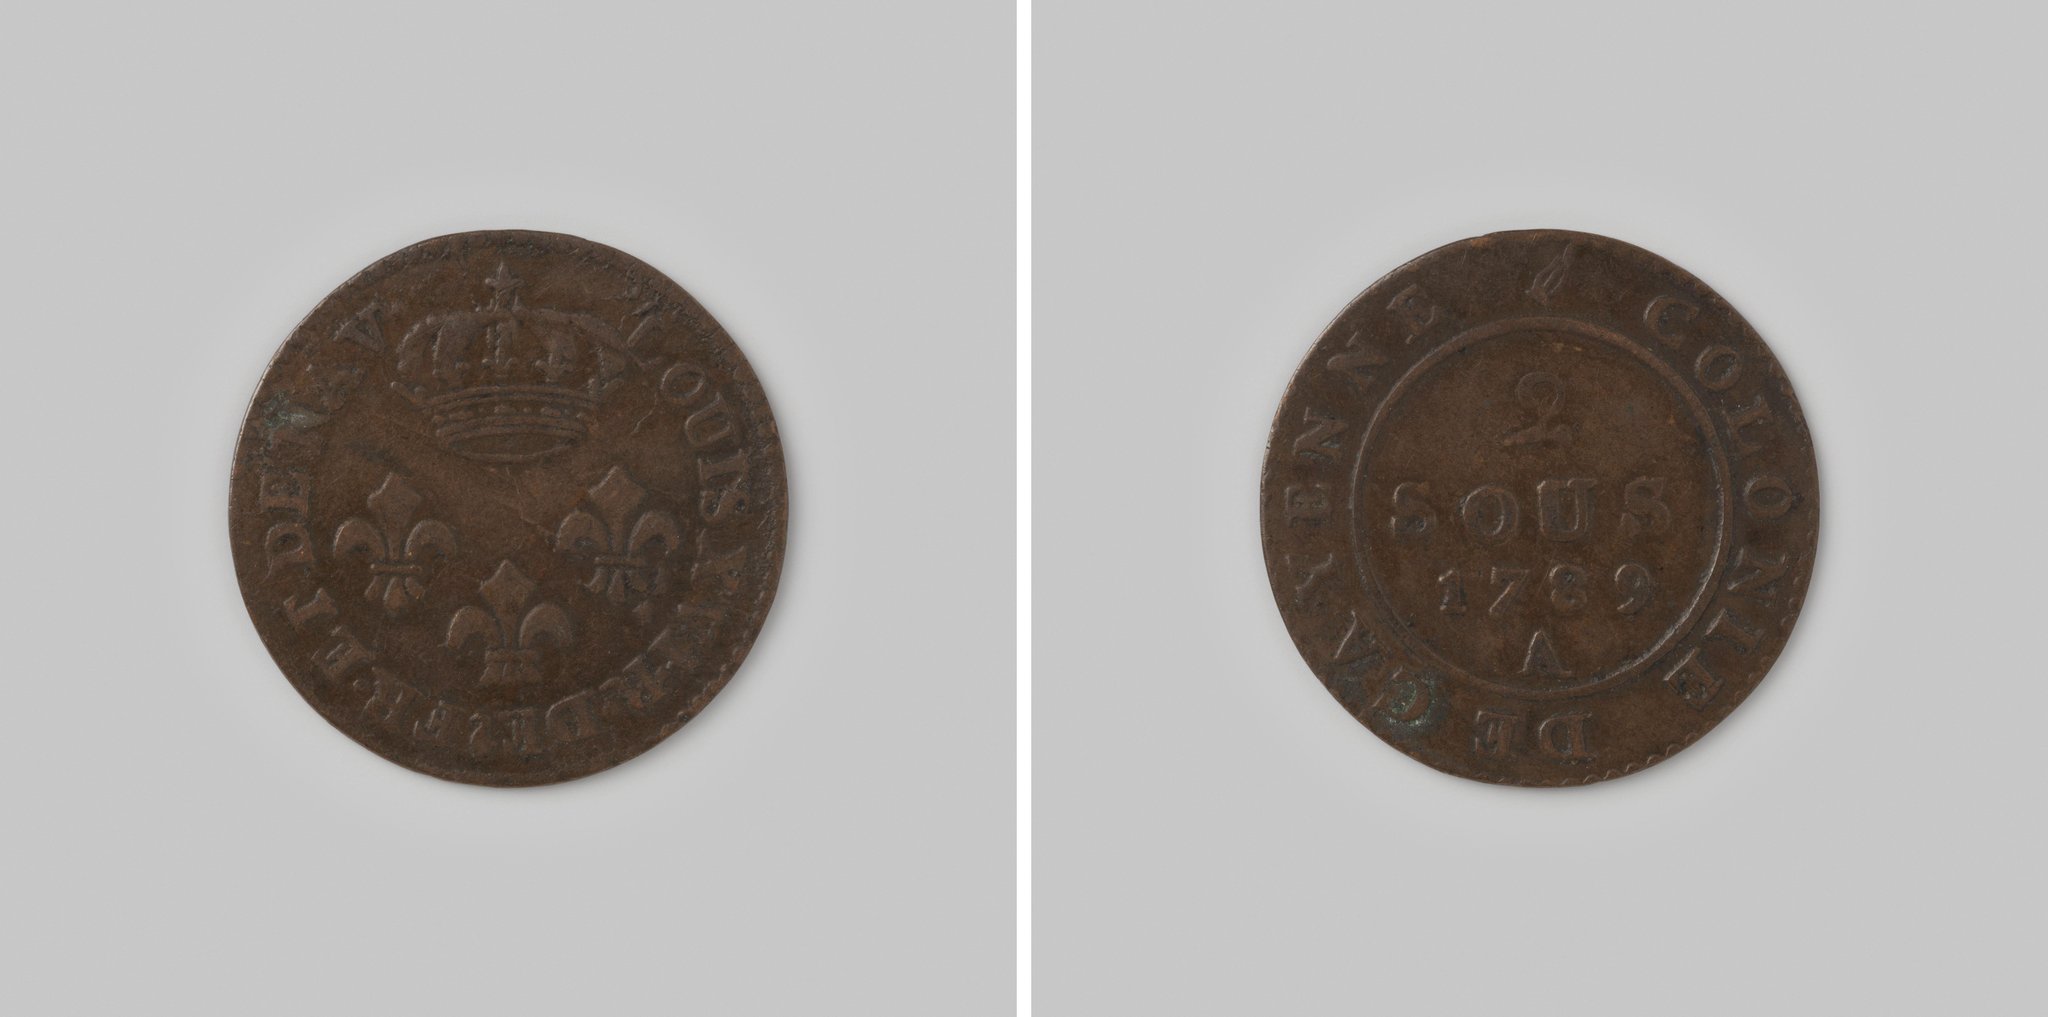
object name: coin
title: 2 sous uit Frans Guiana (Cayenne) van koning Lodewijk XVI,1789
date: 1789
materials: copper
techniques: striking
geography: paris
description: Koperen munt. Voorzijde: drie lelies, waarboven kroon. Keerzijde: waarde-aanduiding: 2 sous in twee regels, waaronder jaartal. Daaronder letter A [=Parijs]. Gladde rand. Zogenaamde Cayenne-stuiver.